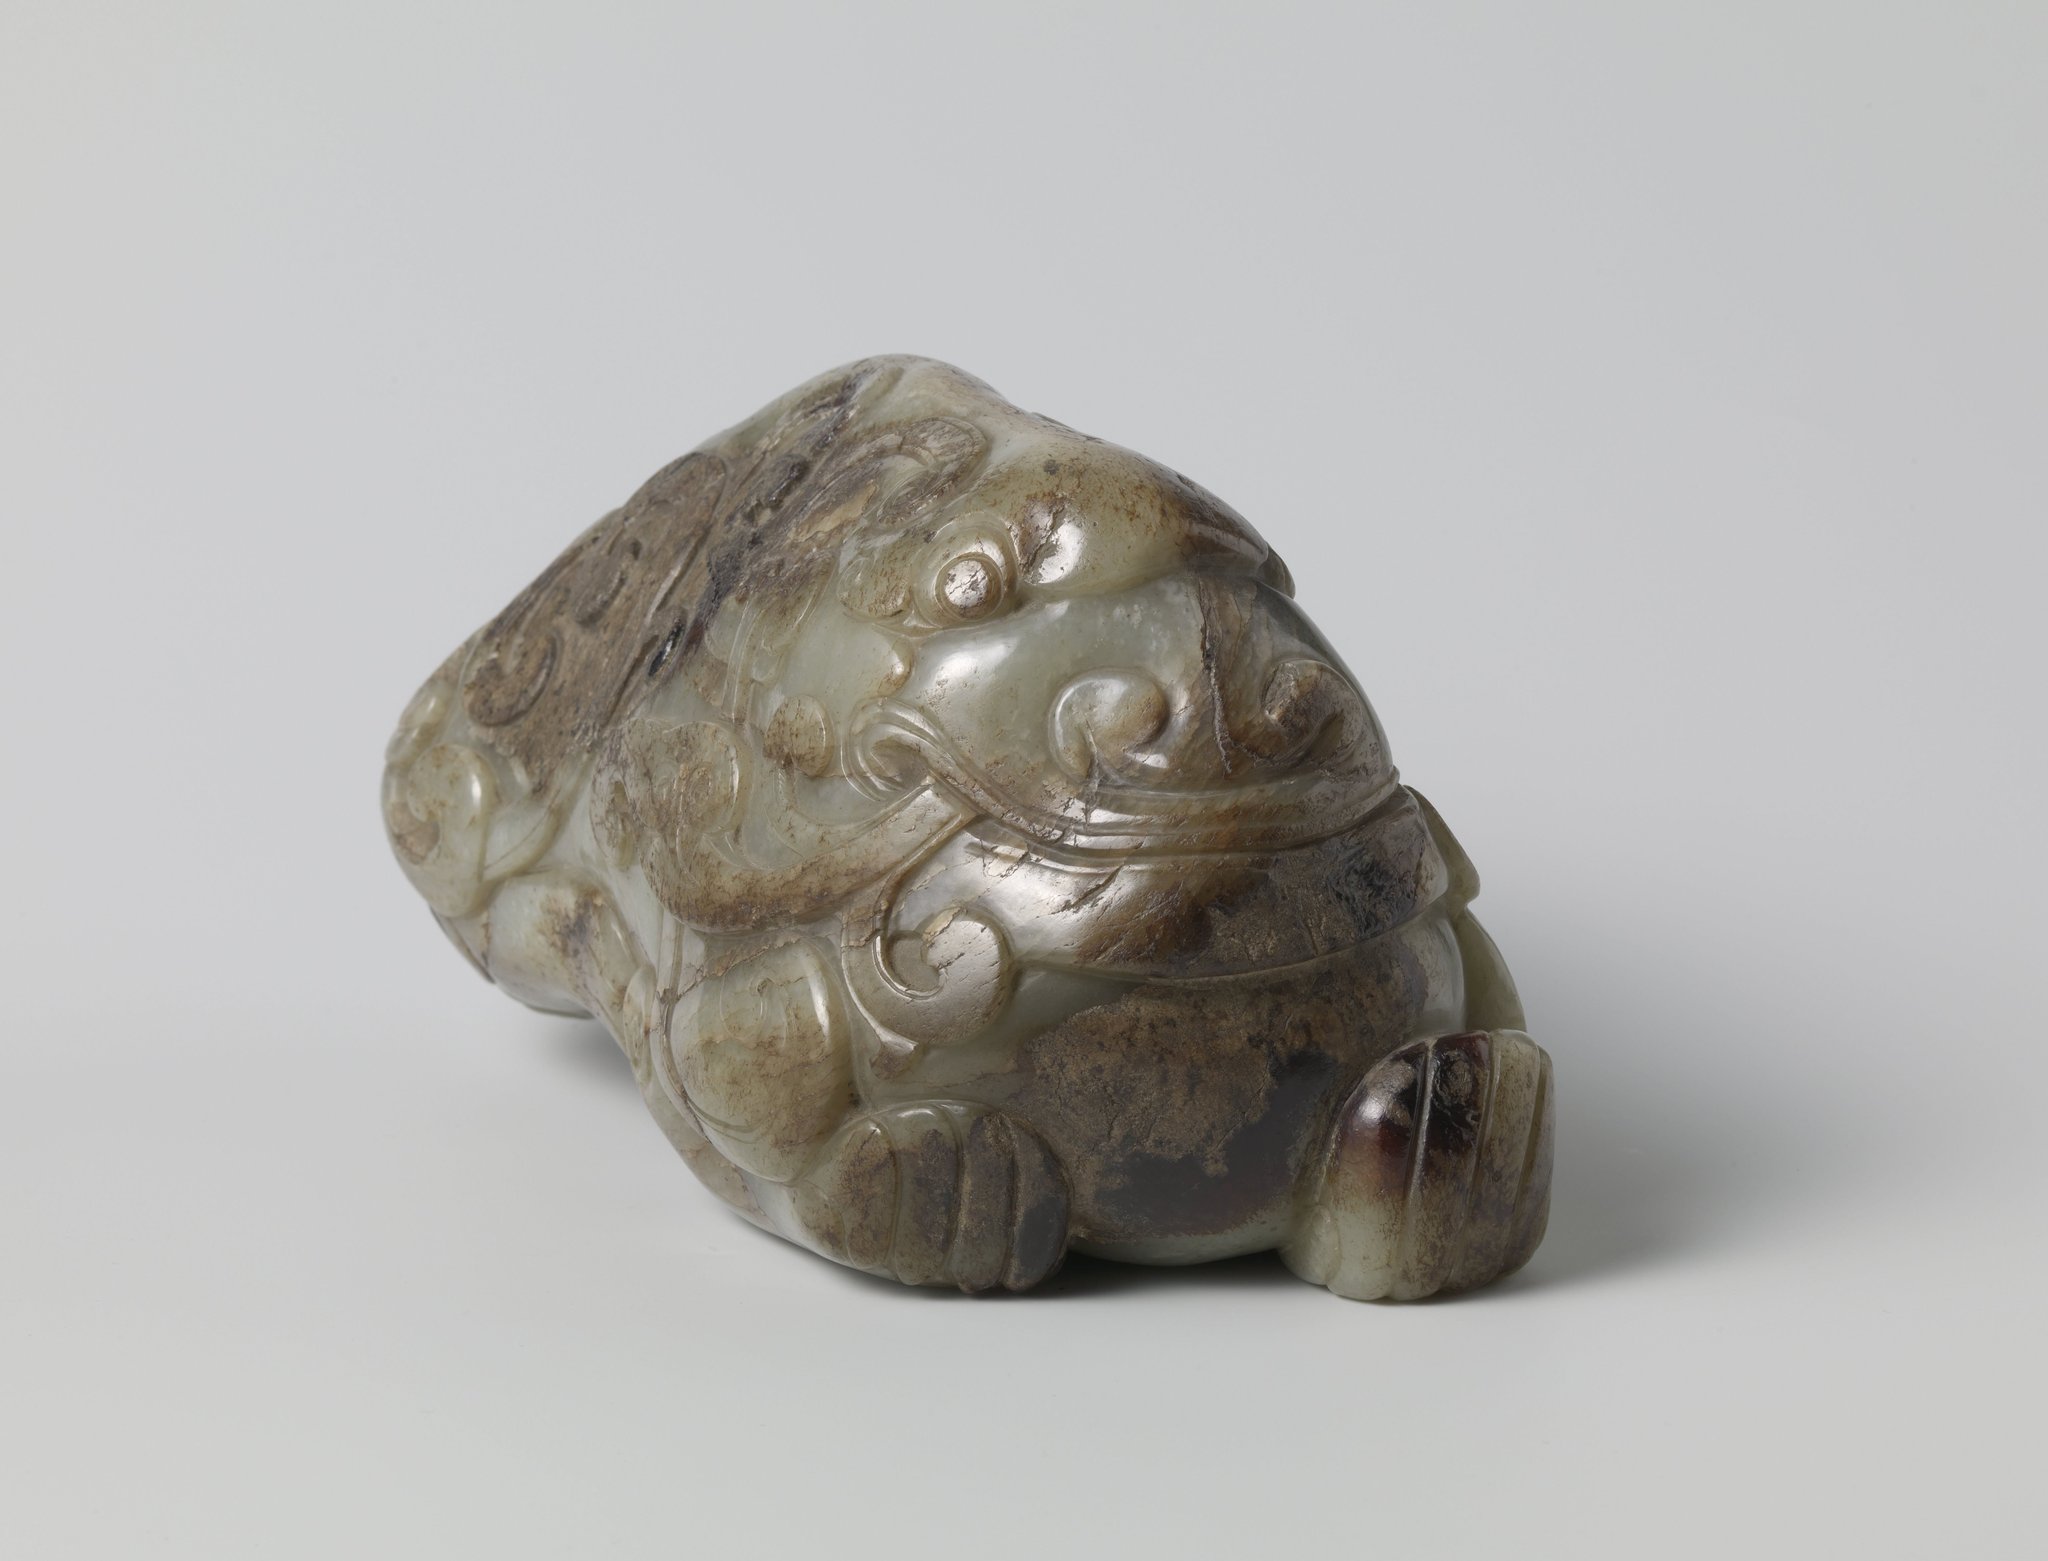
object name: sculpture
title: Fabeldier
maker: Anonymous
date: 1368-1644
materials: jade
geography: china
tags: fabulous animals (sometimes wrongly called 'grotesques'); 'mostri' (ripa)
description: Liggend fabeldier, versierd in haut- en bas-reliëf en arabesken. Licht grijsgroene jade. Op houten sokkel.